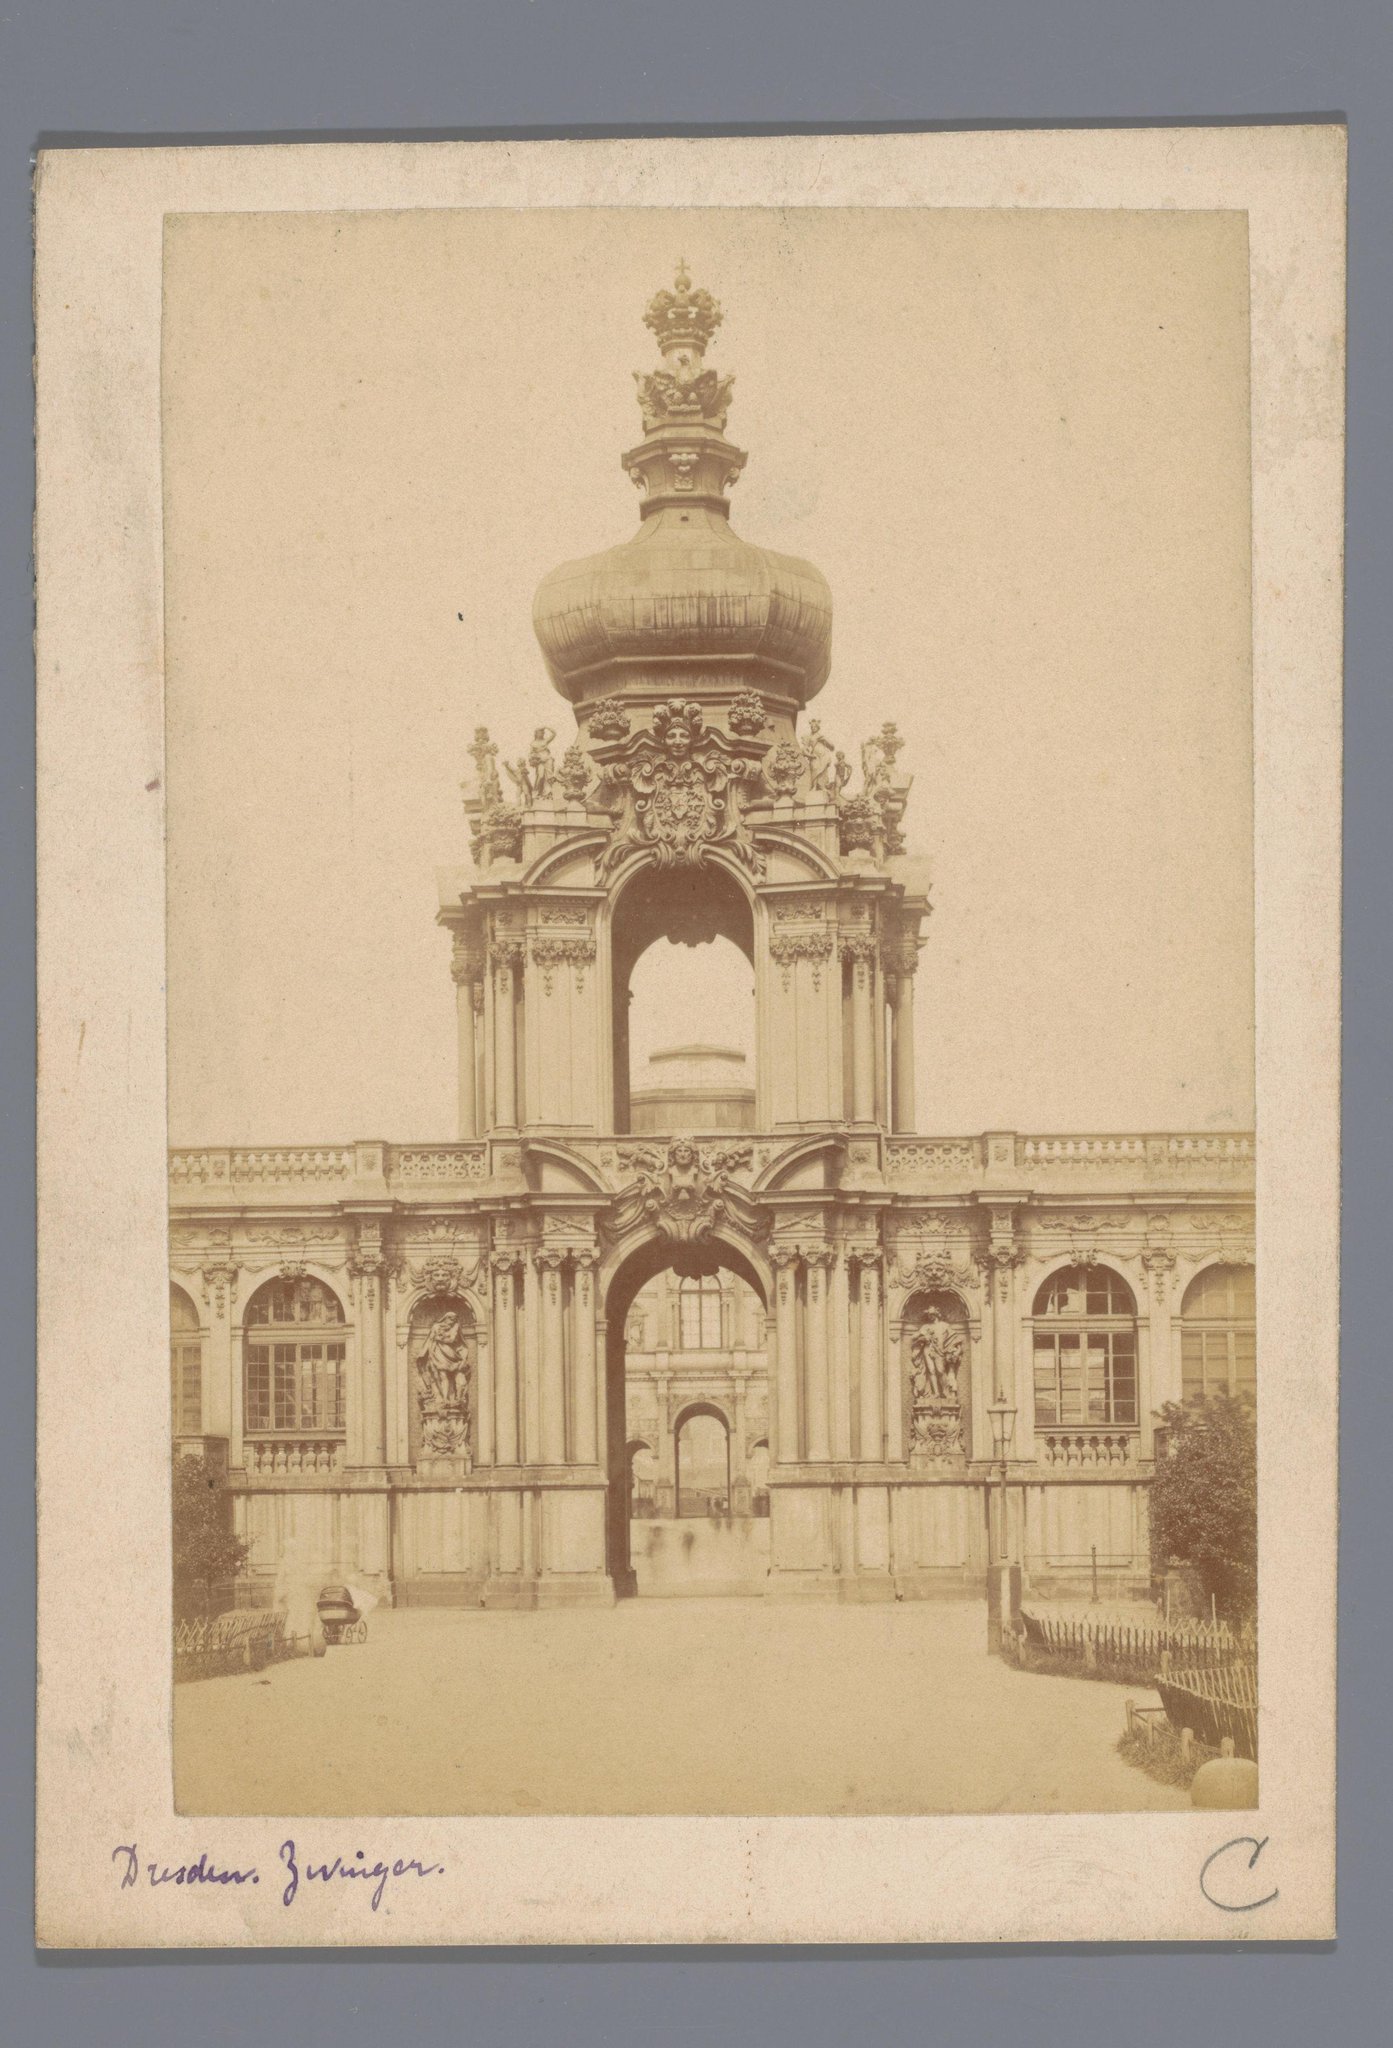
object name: photograph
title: Poort van het Zwinger in Dresden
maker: Anonymous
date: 1850-1890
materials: cardboard, paper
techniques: albumen print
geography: dresden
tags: gate, entrance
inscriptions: inscription: ‘Dresden. Zwinger.’, inscription: ‘C’